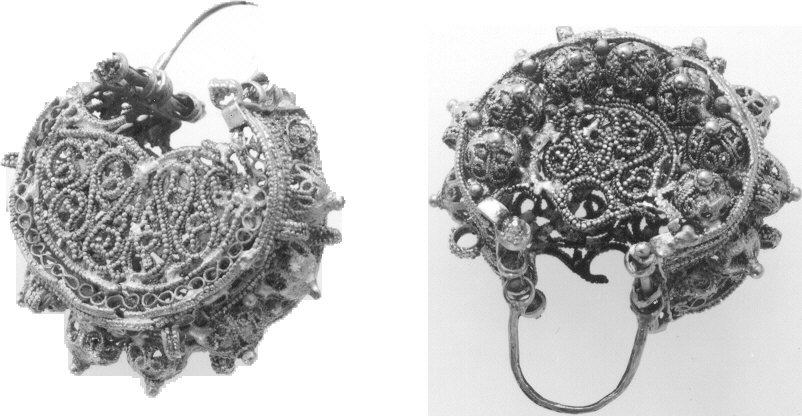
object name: earring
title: Earring, One of a Pair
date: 1001-1100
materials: gold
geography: egypt